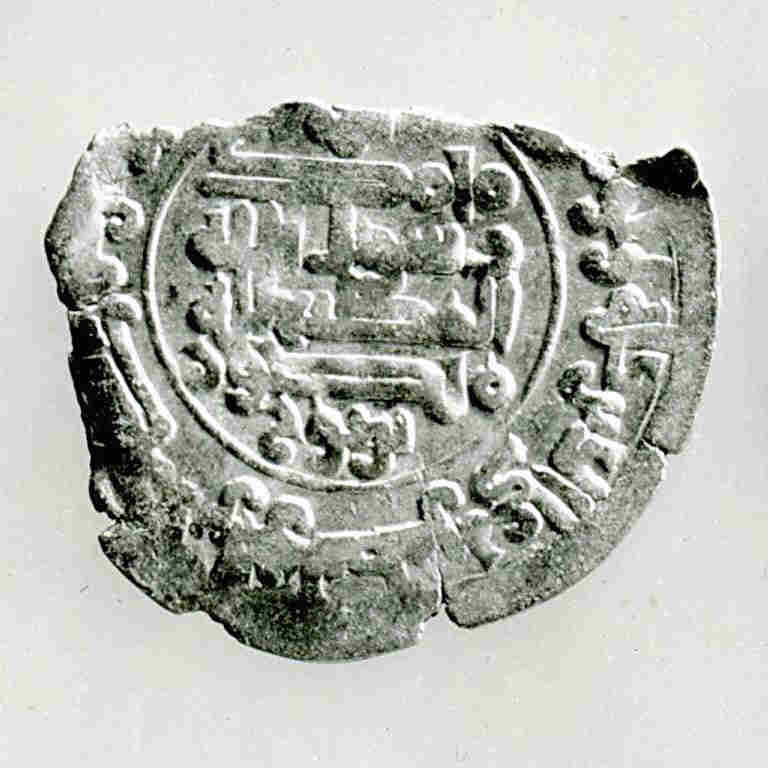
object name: coin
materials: silver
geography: uzbekistan